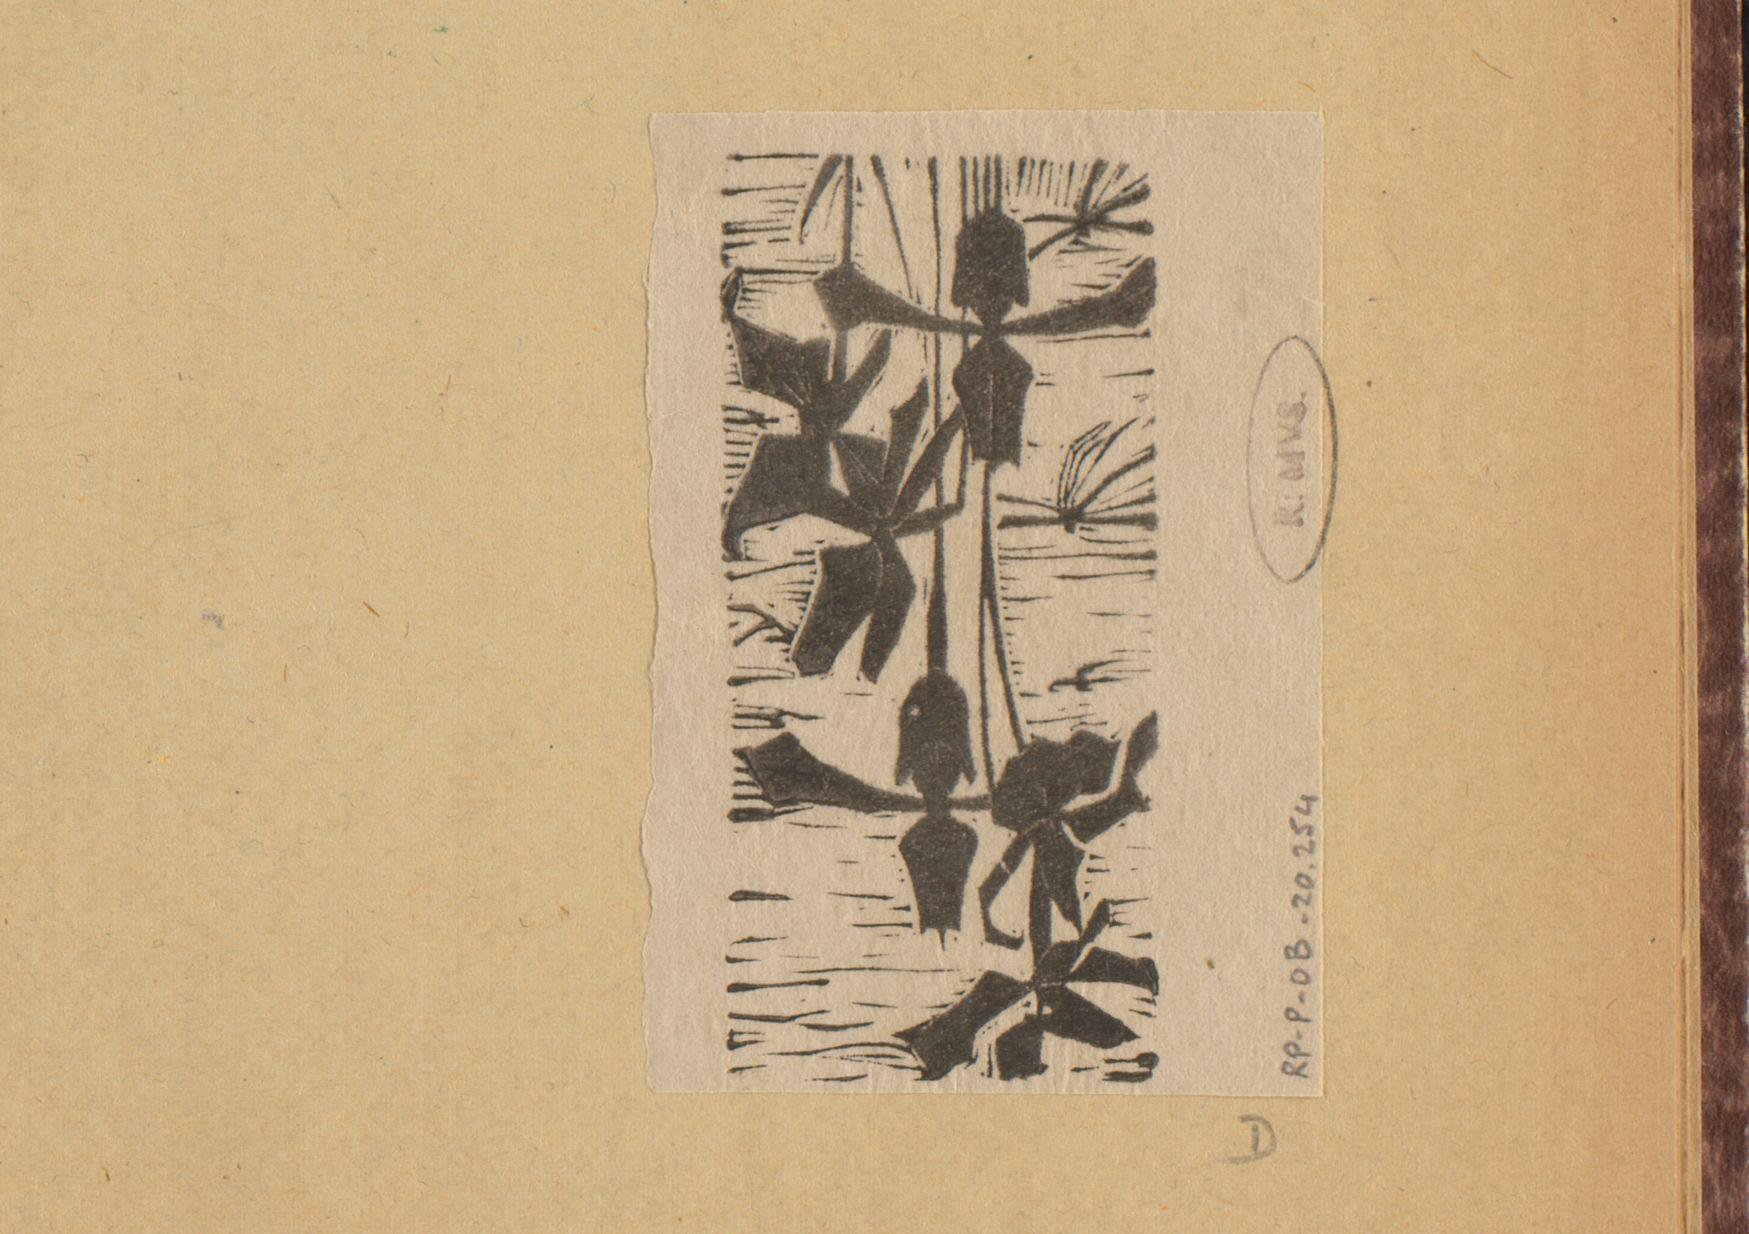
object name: album leaf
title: Orchideeën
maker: mathieu lauweriks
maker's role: designer, draughtsman, print maker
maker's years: 1864-1932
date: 1895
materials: paper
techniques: woodcut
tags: flowers: orchid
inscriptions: collector's mark: Lugt 2228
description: Deze prent maakt deel uit van een album.